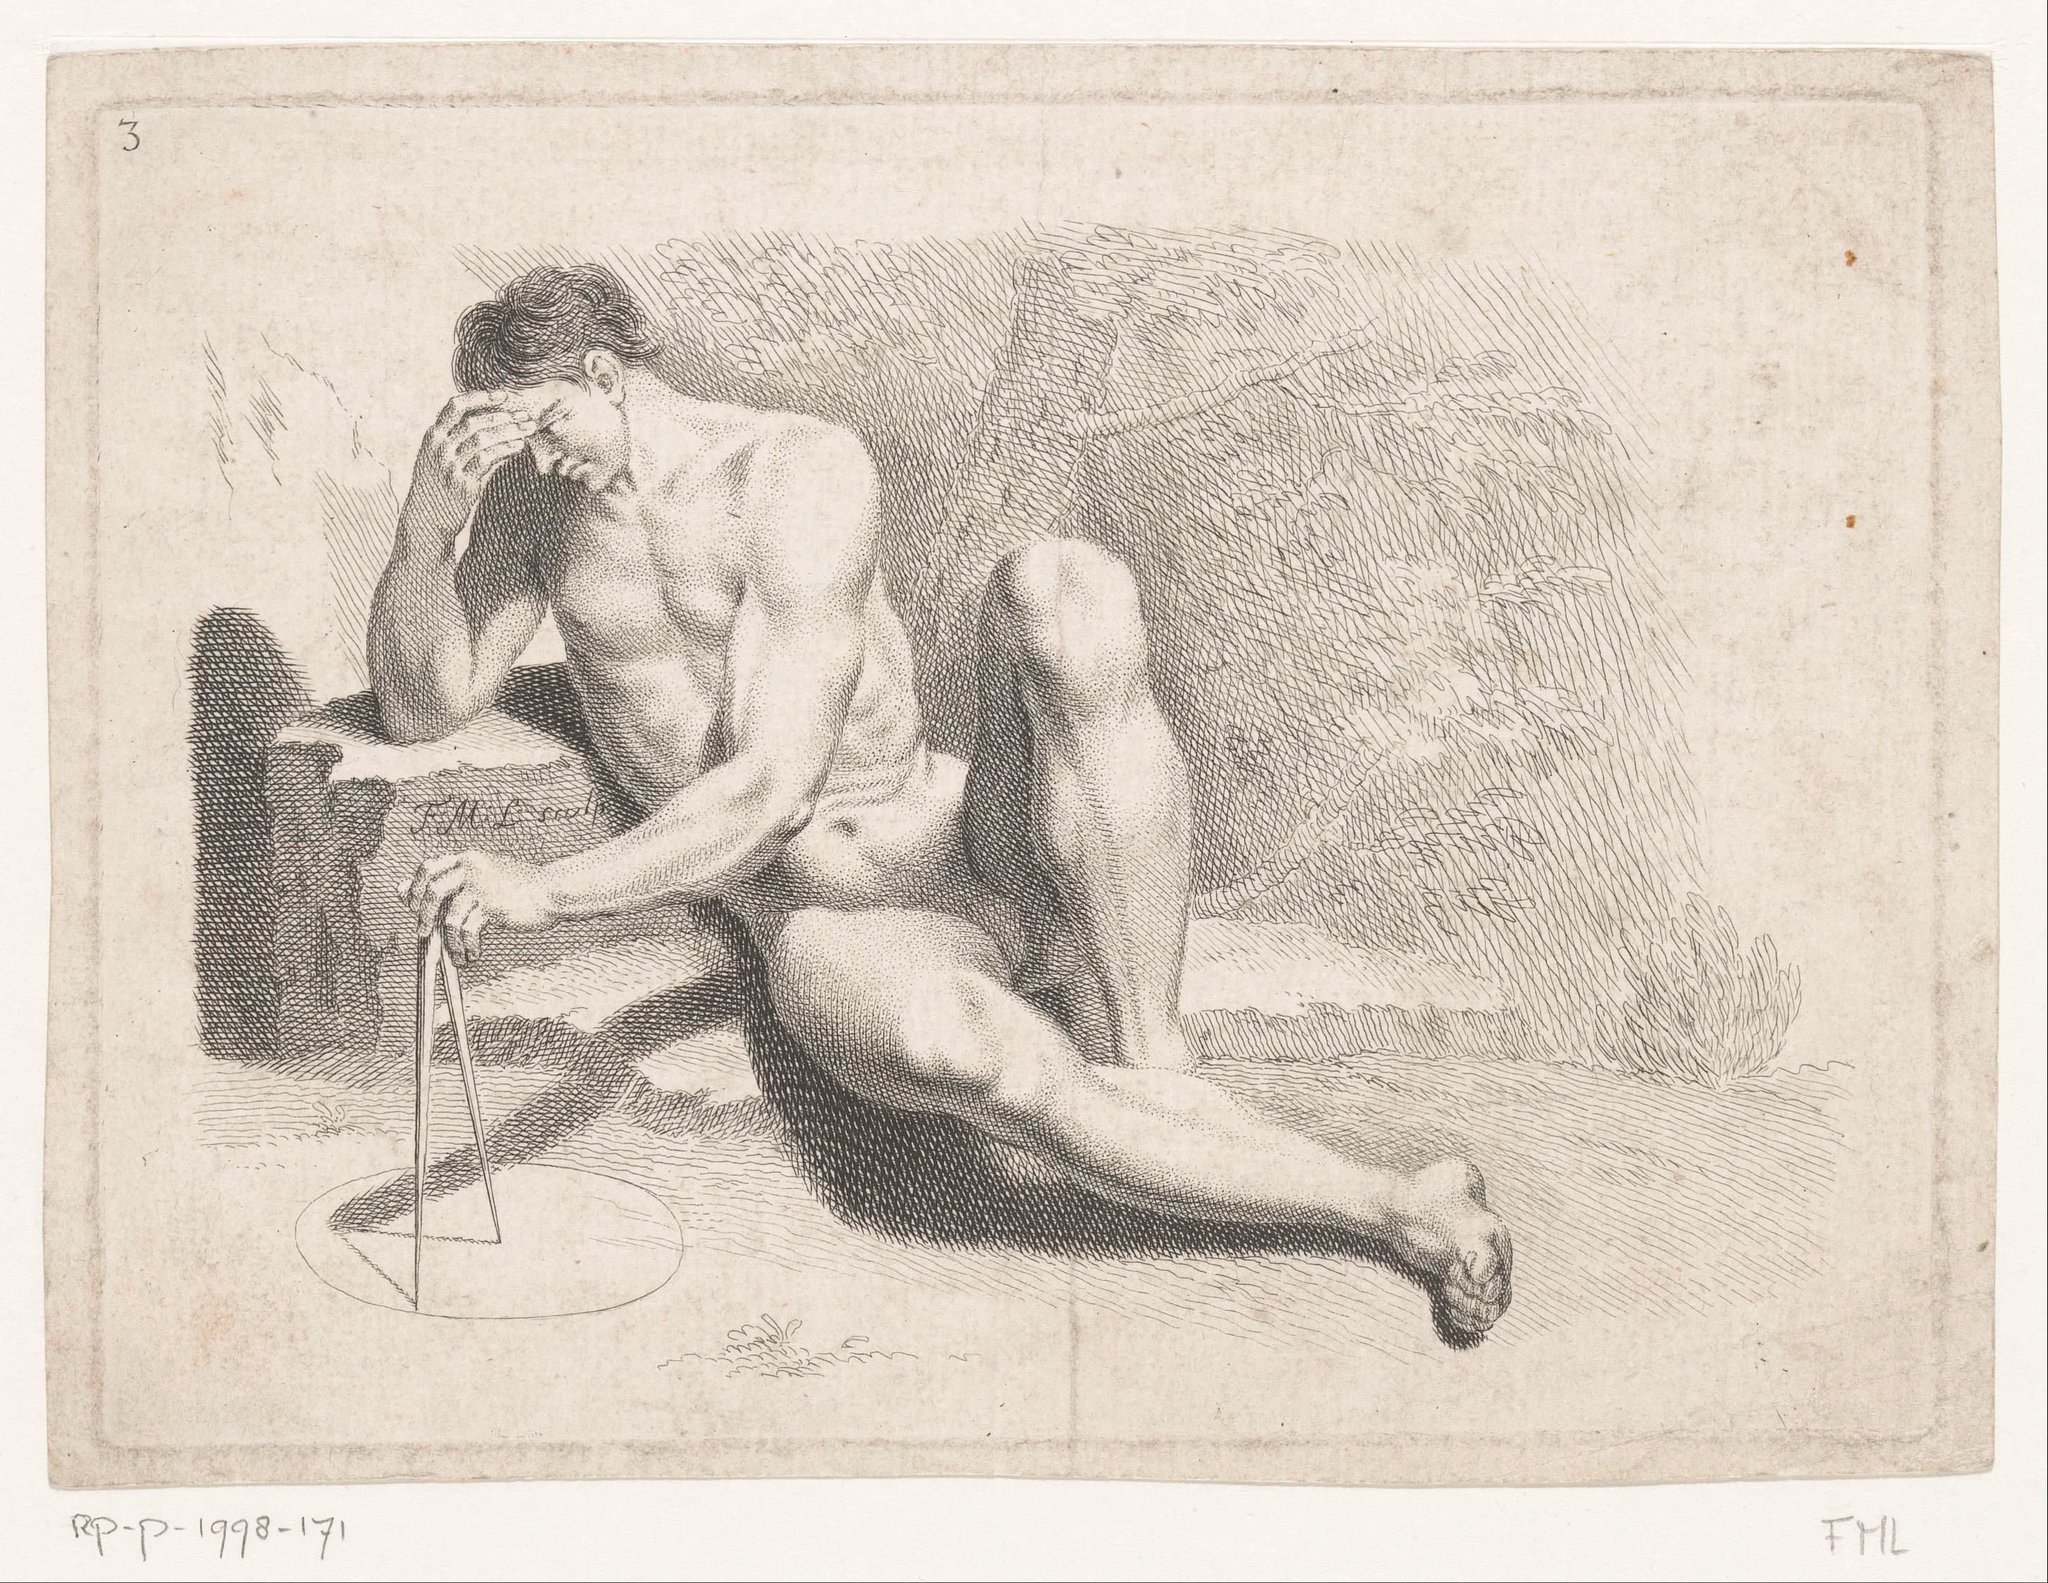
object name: print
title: Zittende naakte man met passer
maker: monogrammist fml (prentmaker)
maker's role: print maker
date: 1751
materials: paper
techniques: engraving, etching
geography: netherlands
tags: sitting on the ground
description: Figuurstudie van een zittende naakte man naast een steen. Met een passer trekt hij een cirkel op de grond.